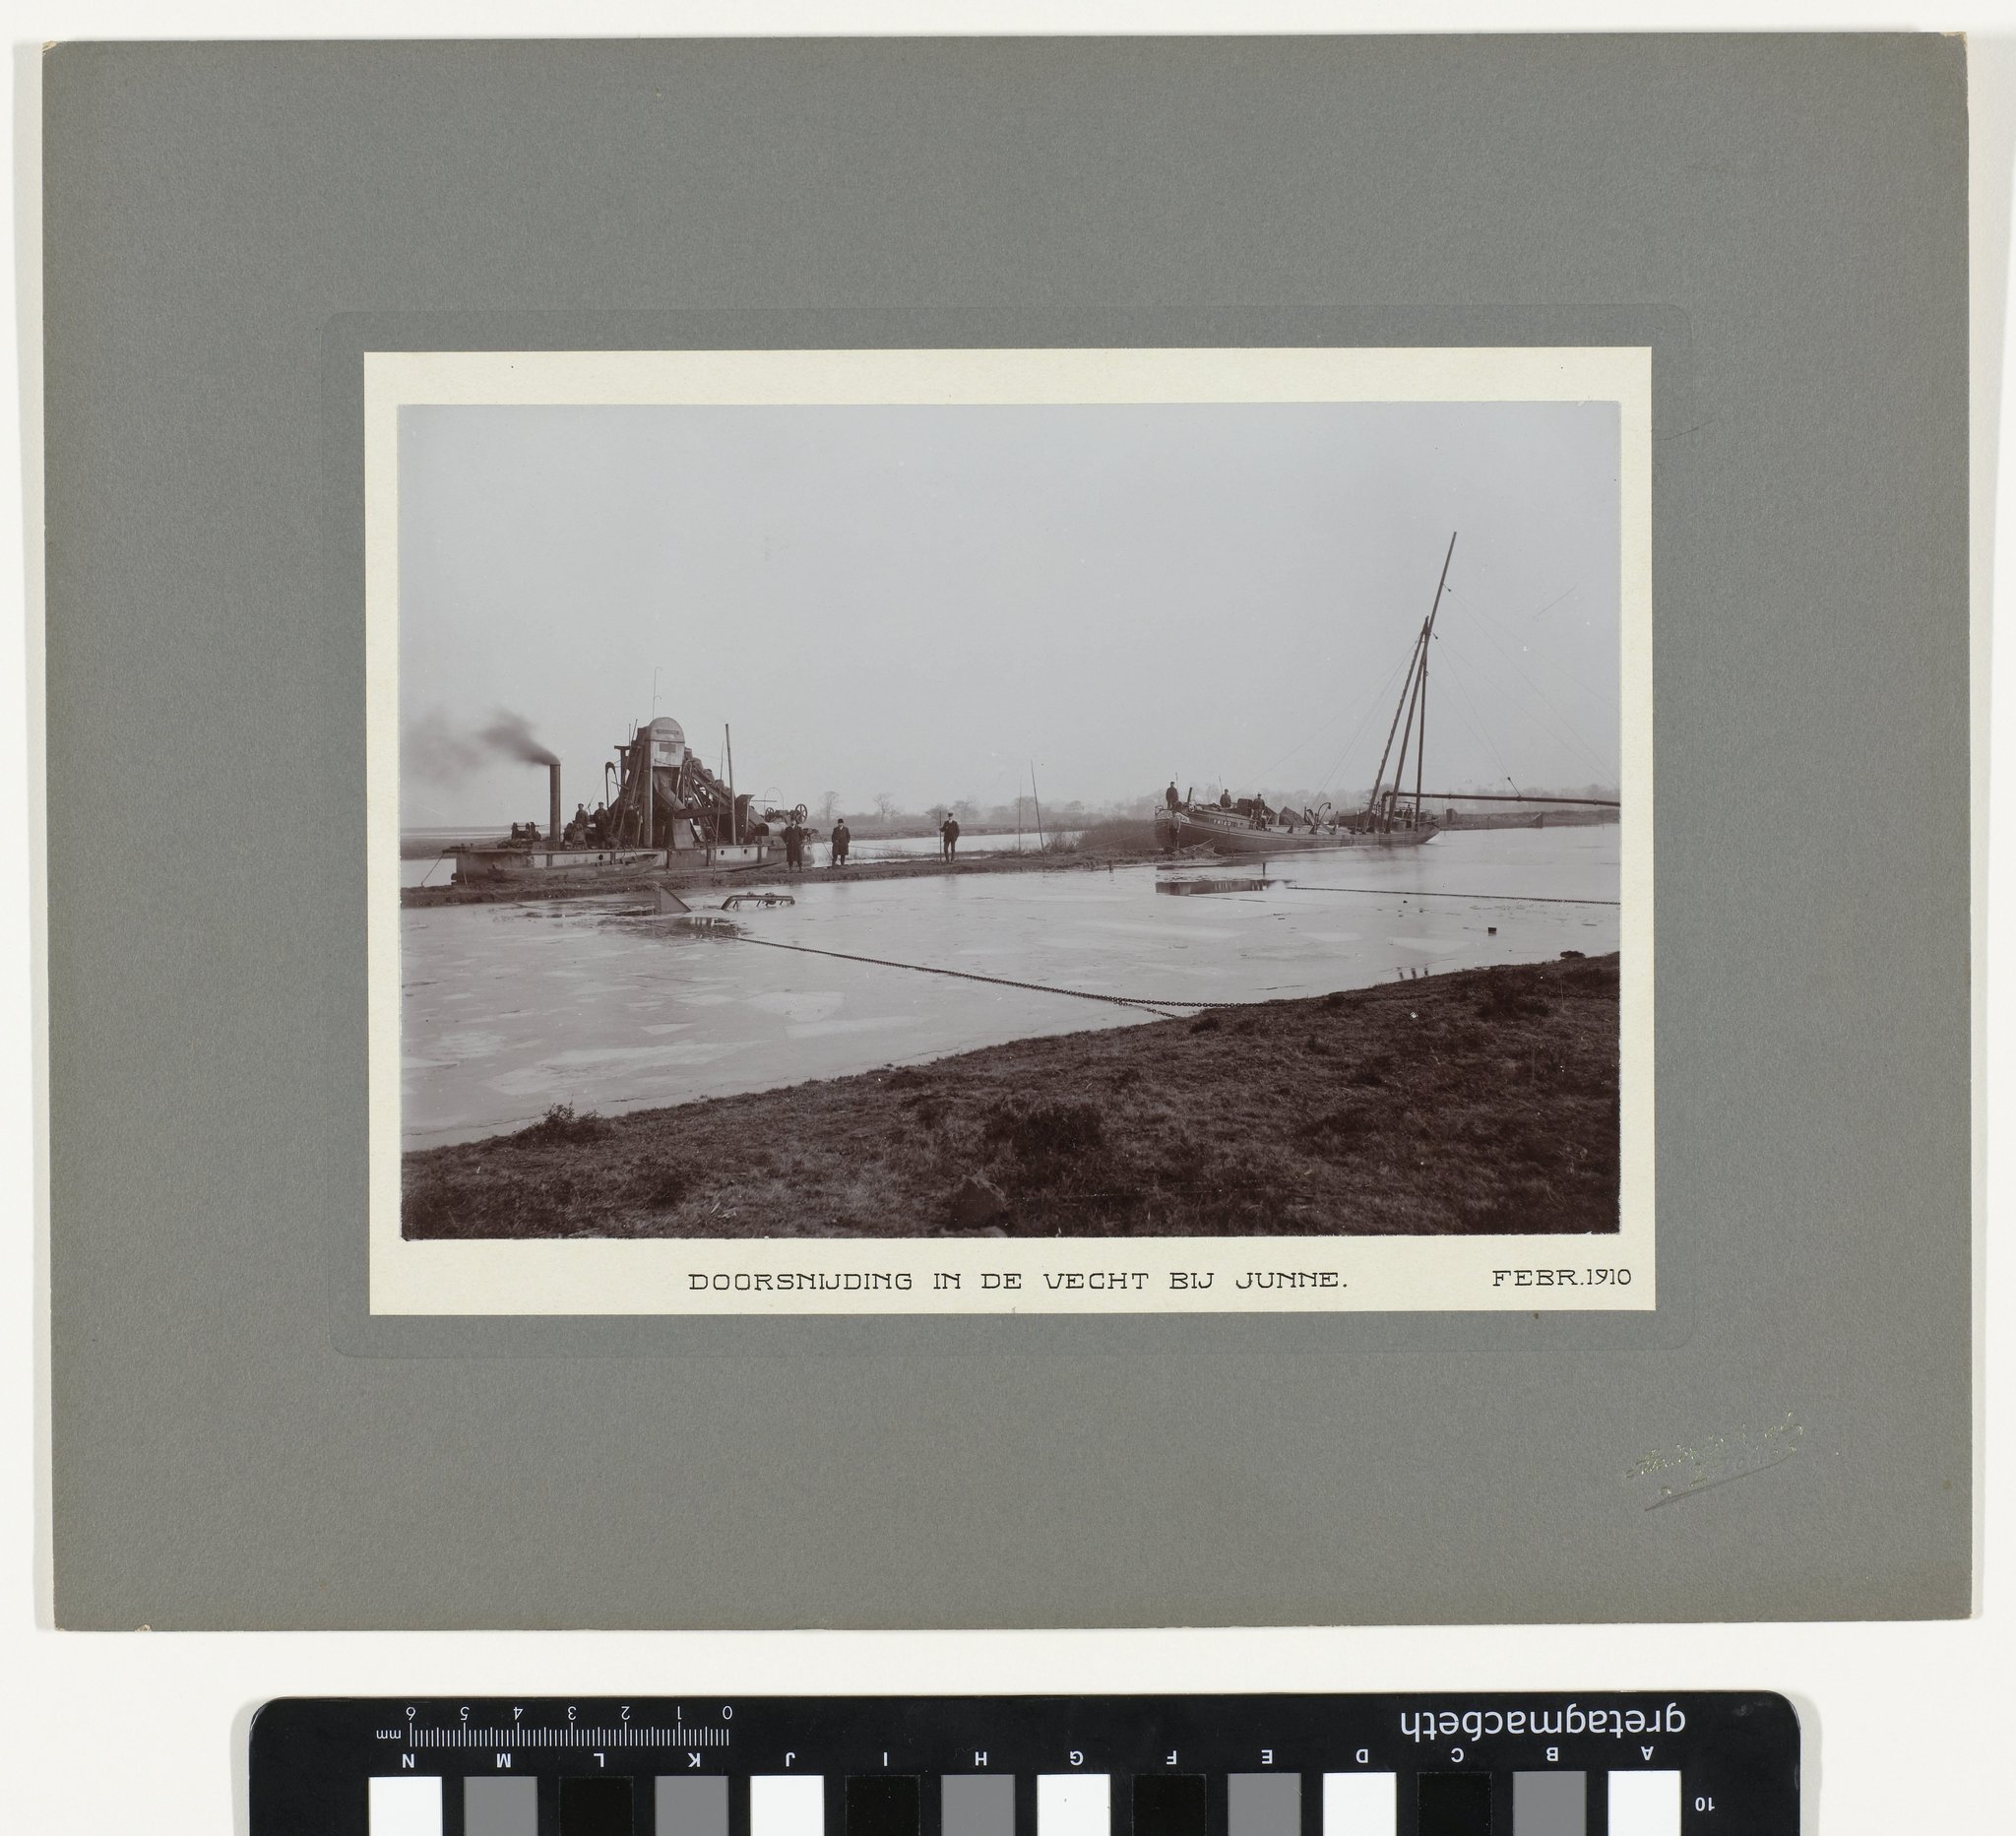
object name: photograph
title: Doorsnijding in de Vecht bij Junne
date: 1902-1910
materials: cardboard, paper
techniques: photography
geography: zwolle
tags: overijssel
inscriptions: date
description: Foto van waterbouwkundige werken (aan het Vecht te Overijssel).